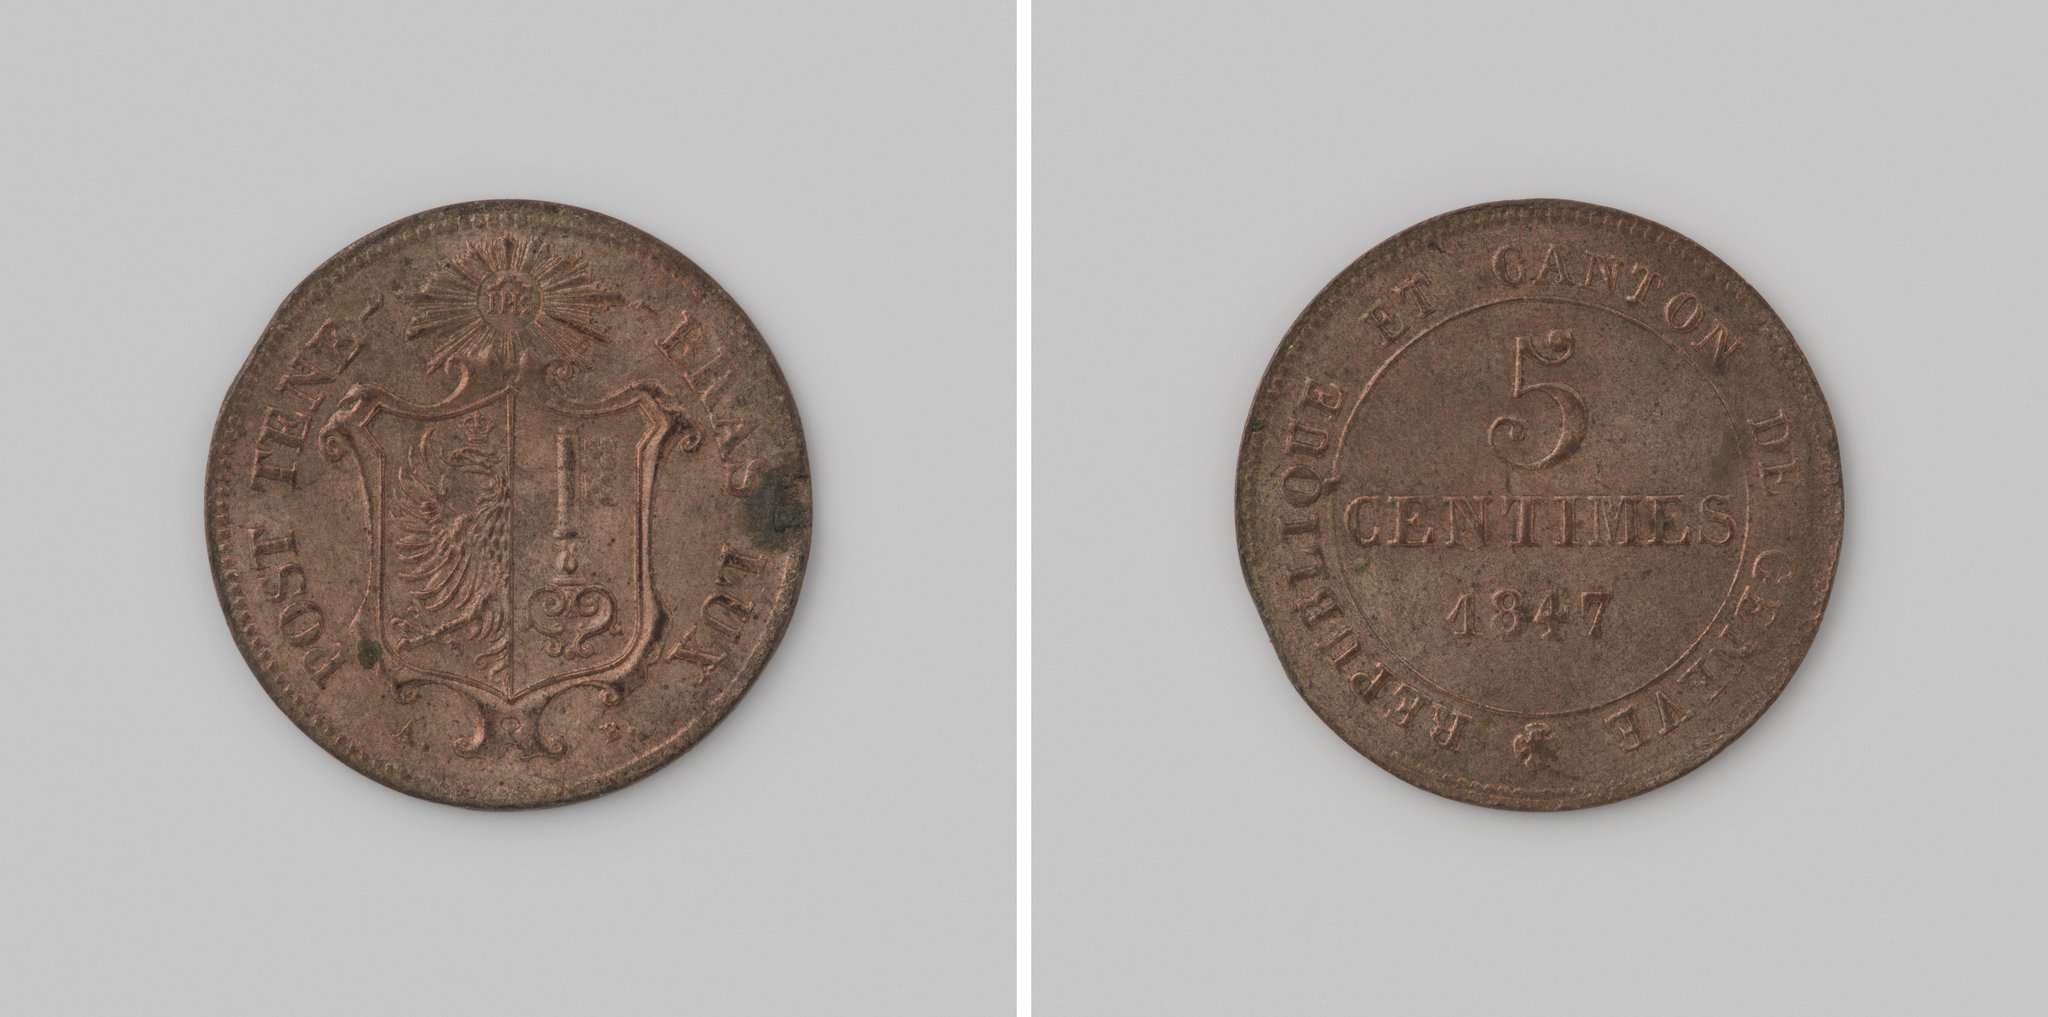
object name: vijf centime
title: Kanton Geneve, 5 centimes, 1847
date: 1847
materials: silver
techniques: striking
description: Zilveren munt. Voorzijde: versierd wapenschild van Geneve. Daarboven binnen stralende zon de letters I,H en S. Keerzijde: waarde-aanduiding in twee regels, waaronder jaartal. Gladde rand.